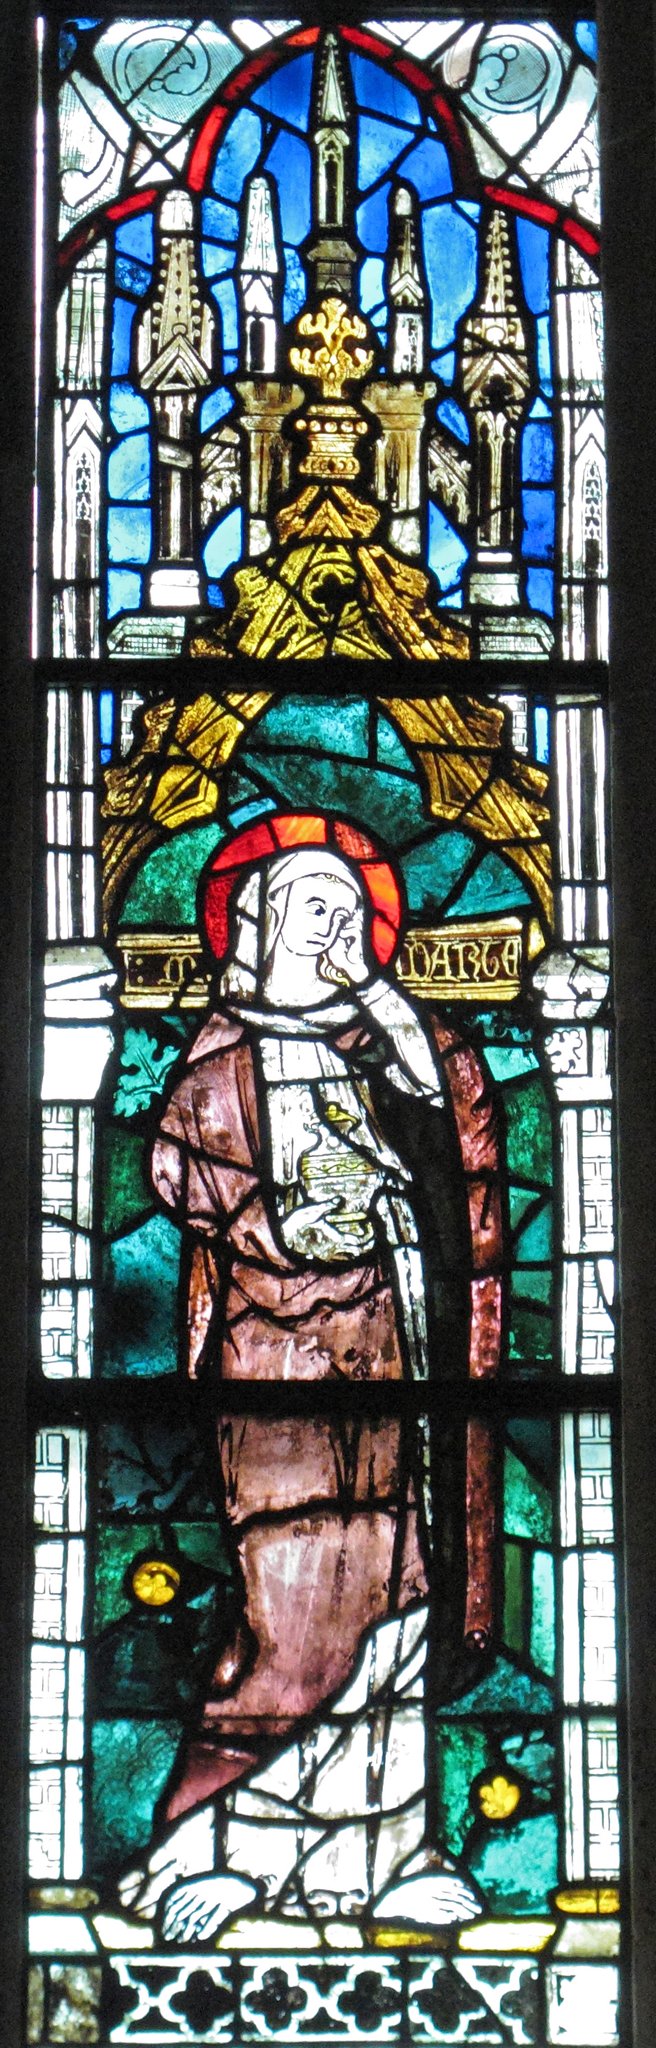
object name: stained glass panel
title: Saint Mary Magdalene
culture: french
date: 1325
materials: glass, metal, paint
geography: france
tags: women,mary magdalene